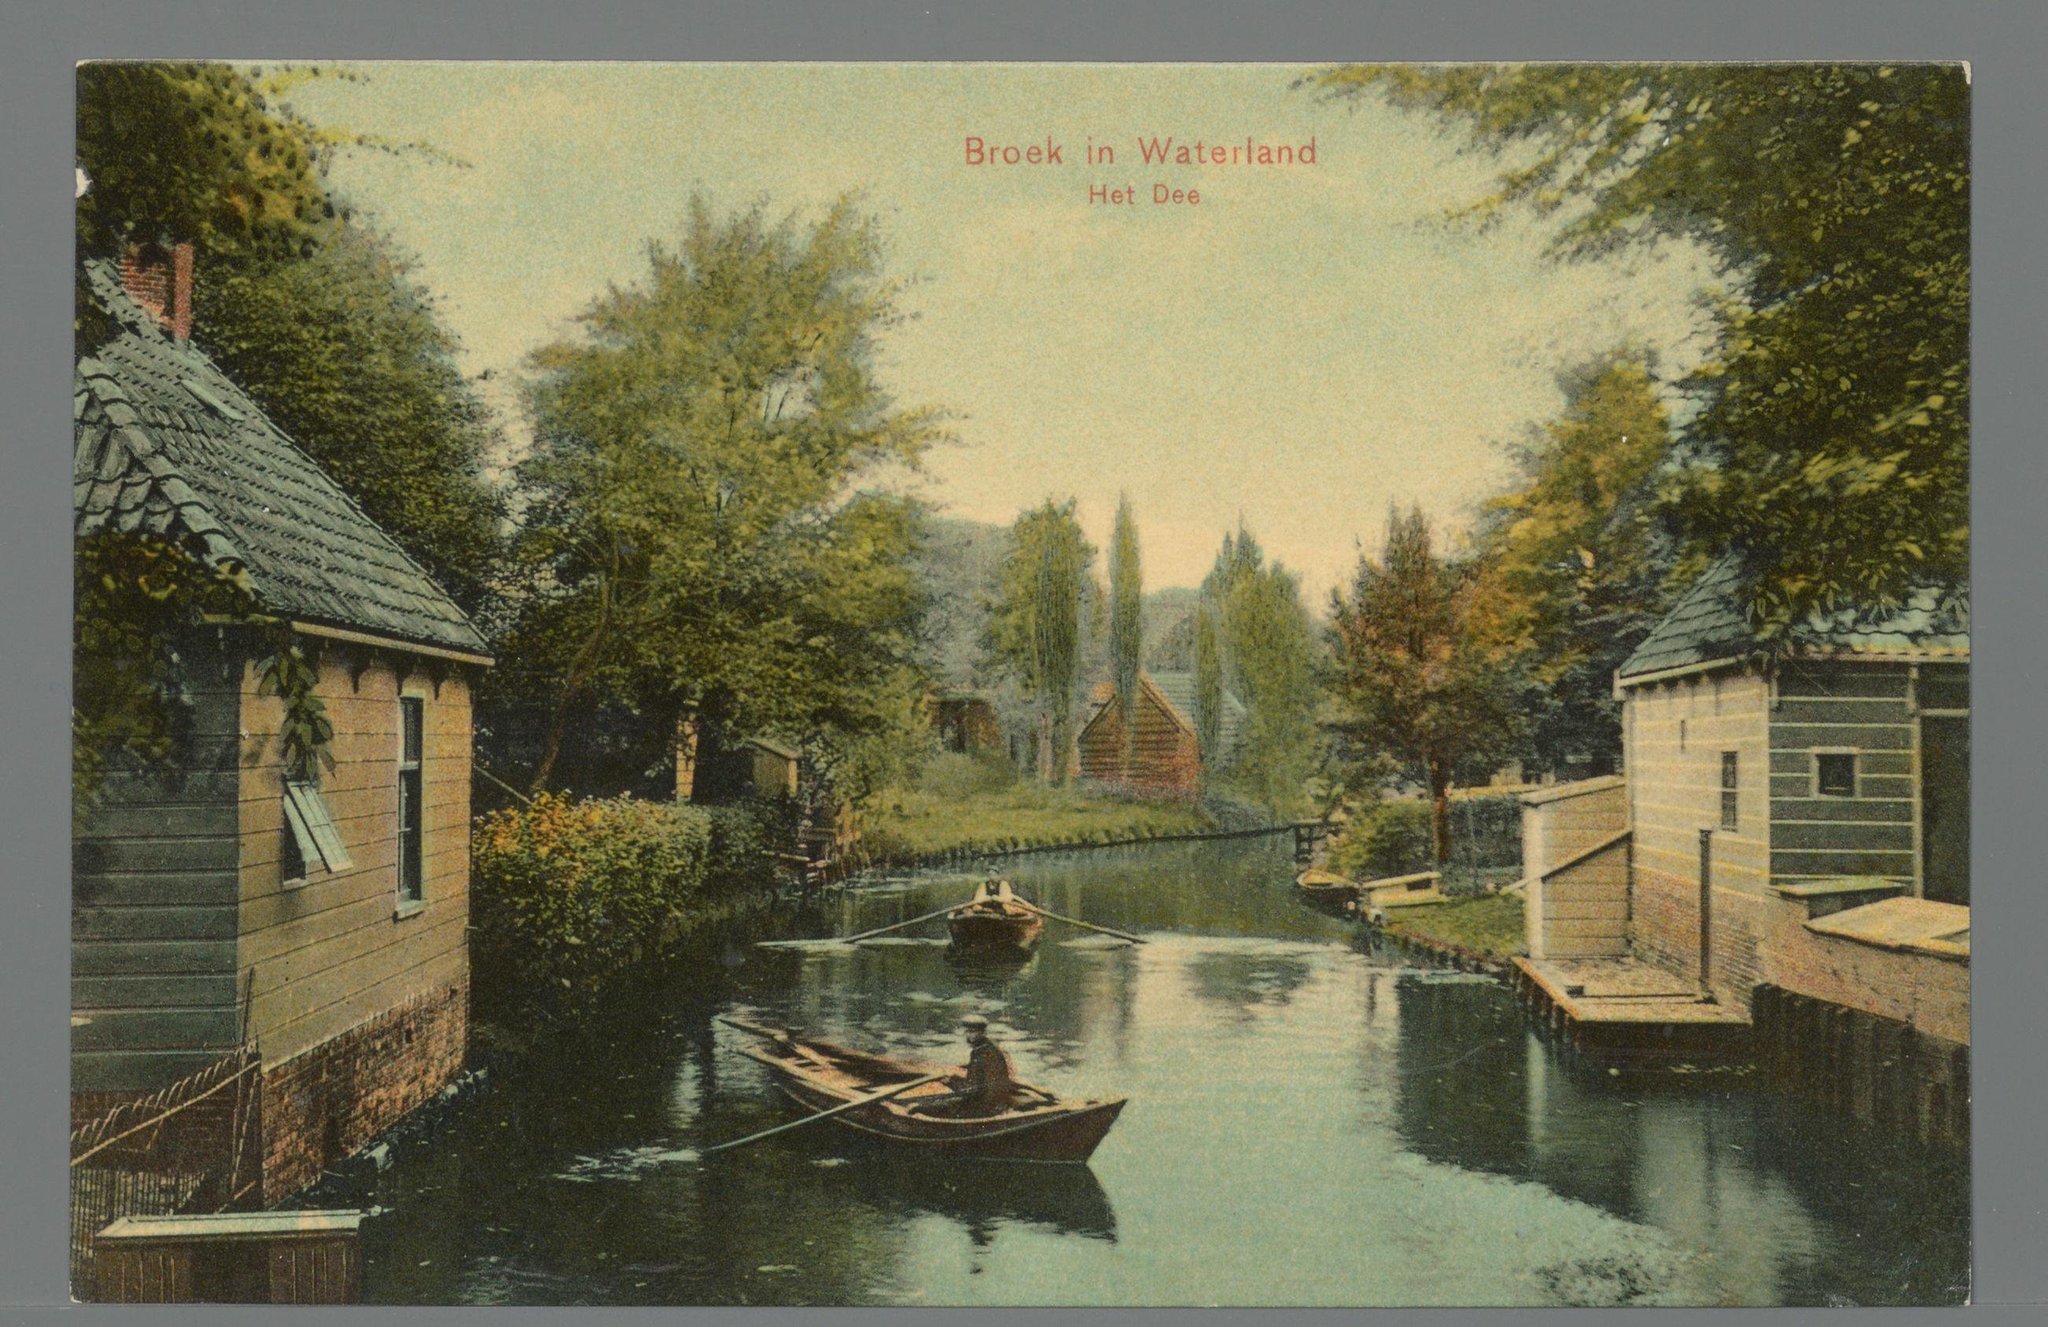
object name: photomechanical print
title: Broek in Waterland. Het Dee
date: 1909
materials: cardboard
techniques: photograph, lithograph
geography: broek in waterland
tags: canal, rural housing, e.g. country-house, villa, cottage, rowing-boat, canoe, etc.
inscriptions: date